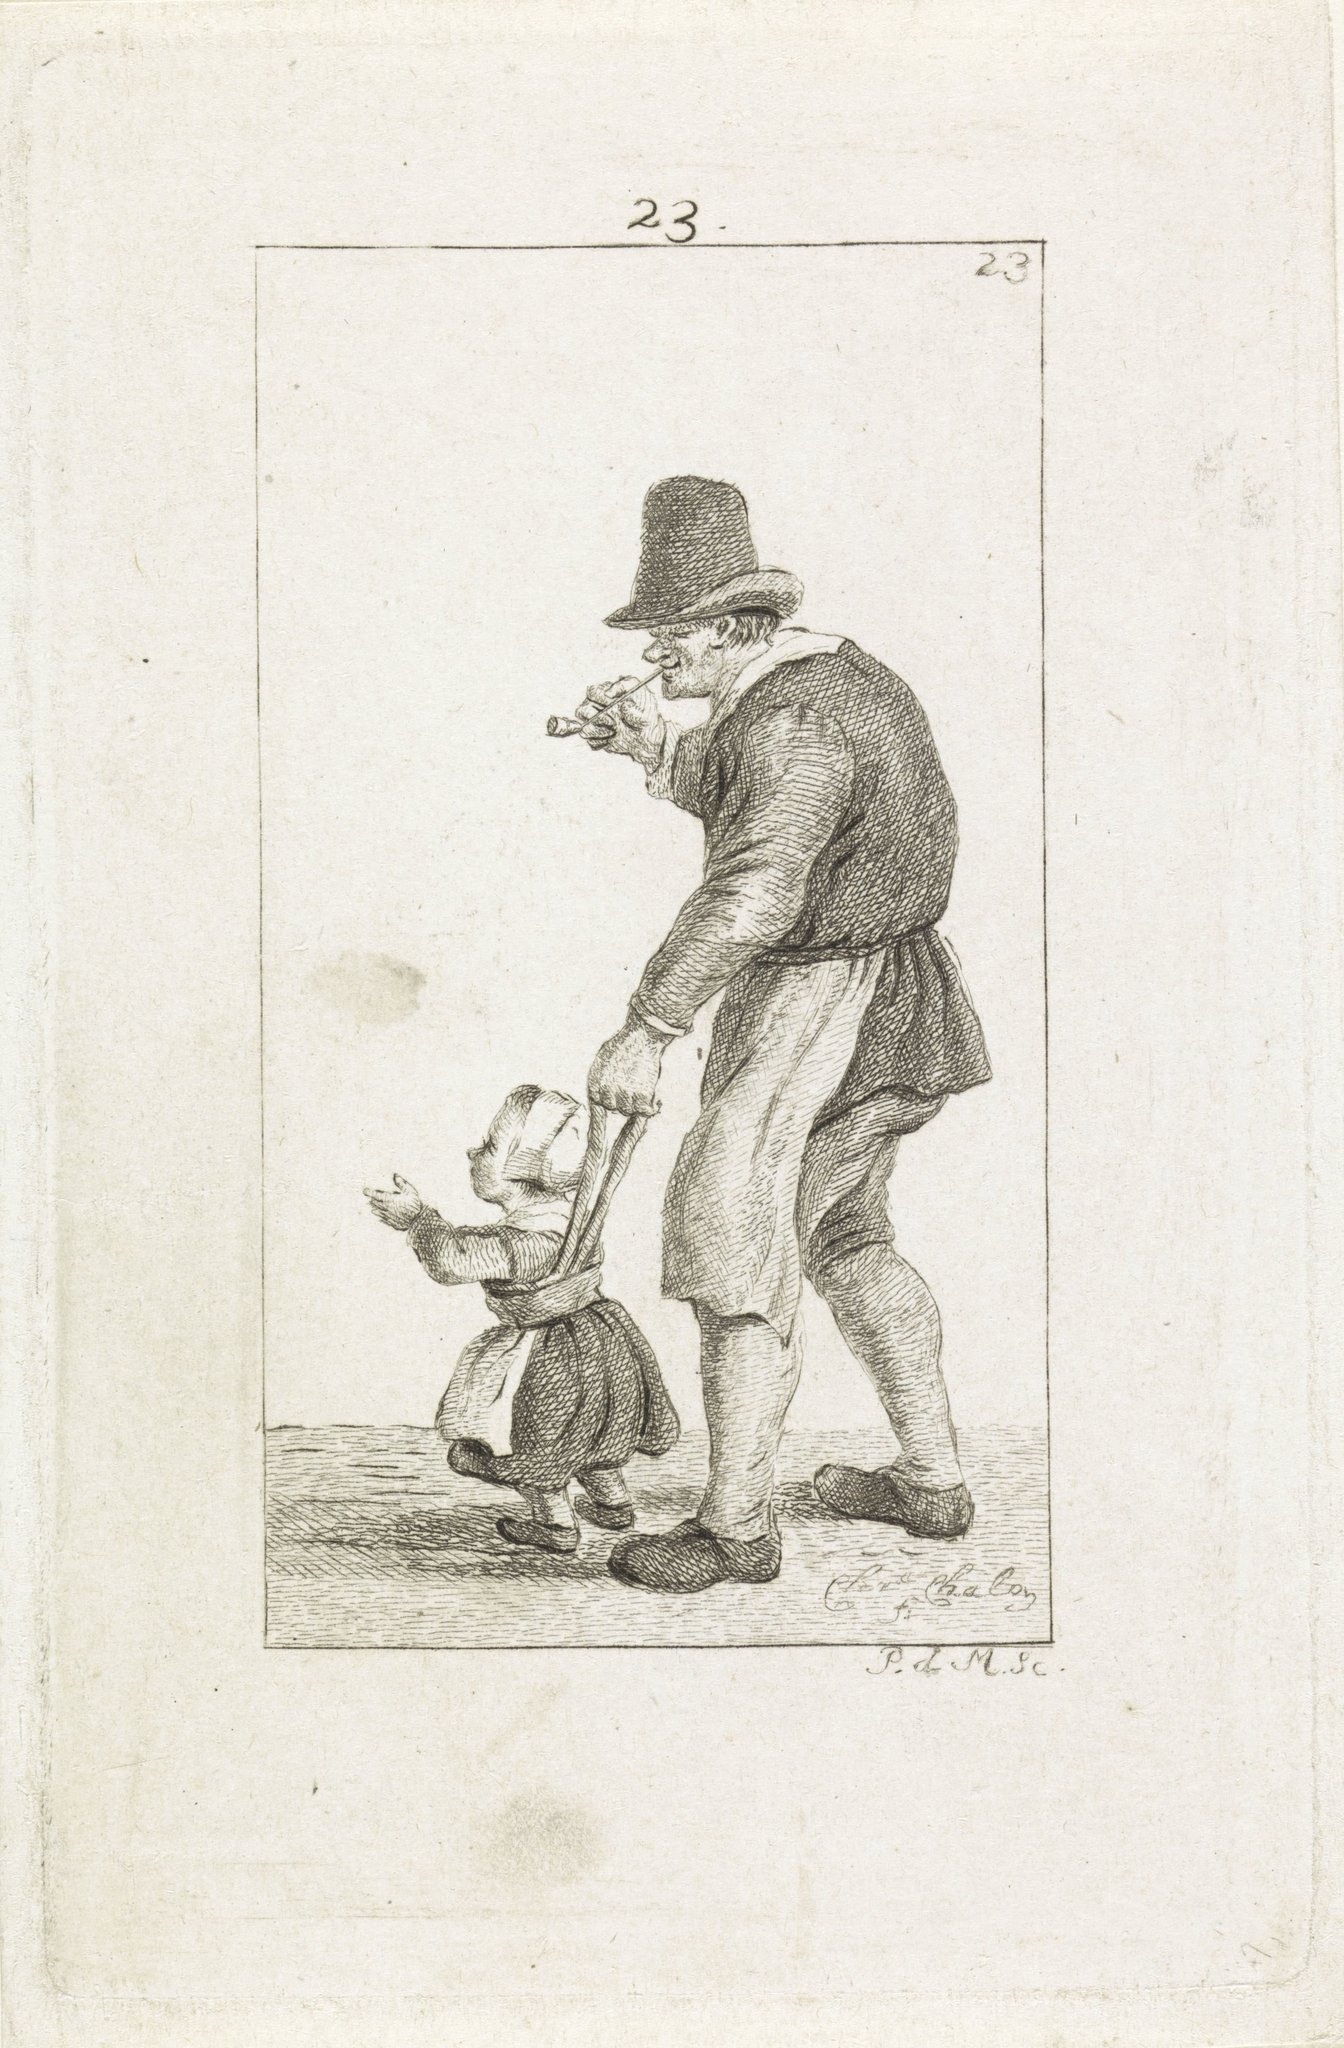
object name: print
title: Man met kind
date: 1779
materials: paper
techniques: engraving, etching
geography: netherlands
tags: folk costume, regional costume, infant, baby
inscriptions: collector's mark: Lugt 2228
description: Man wandelend met een kind in een tuigje. Onderdeel van een reeks illustraties van volksklederdrachten uit 1779.